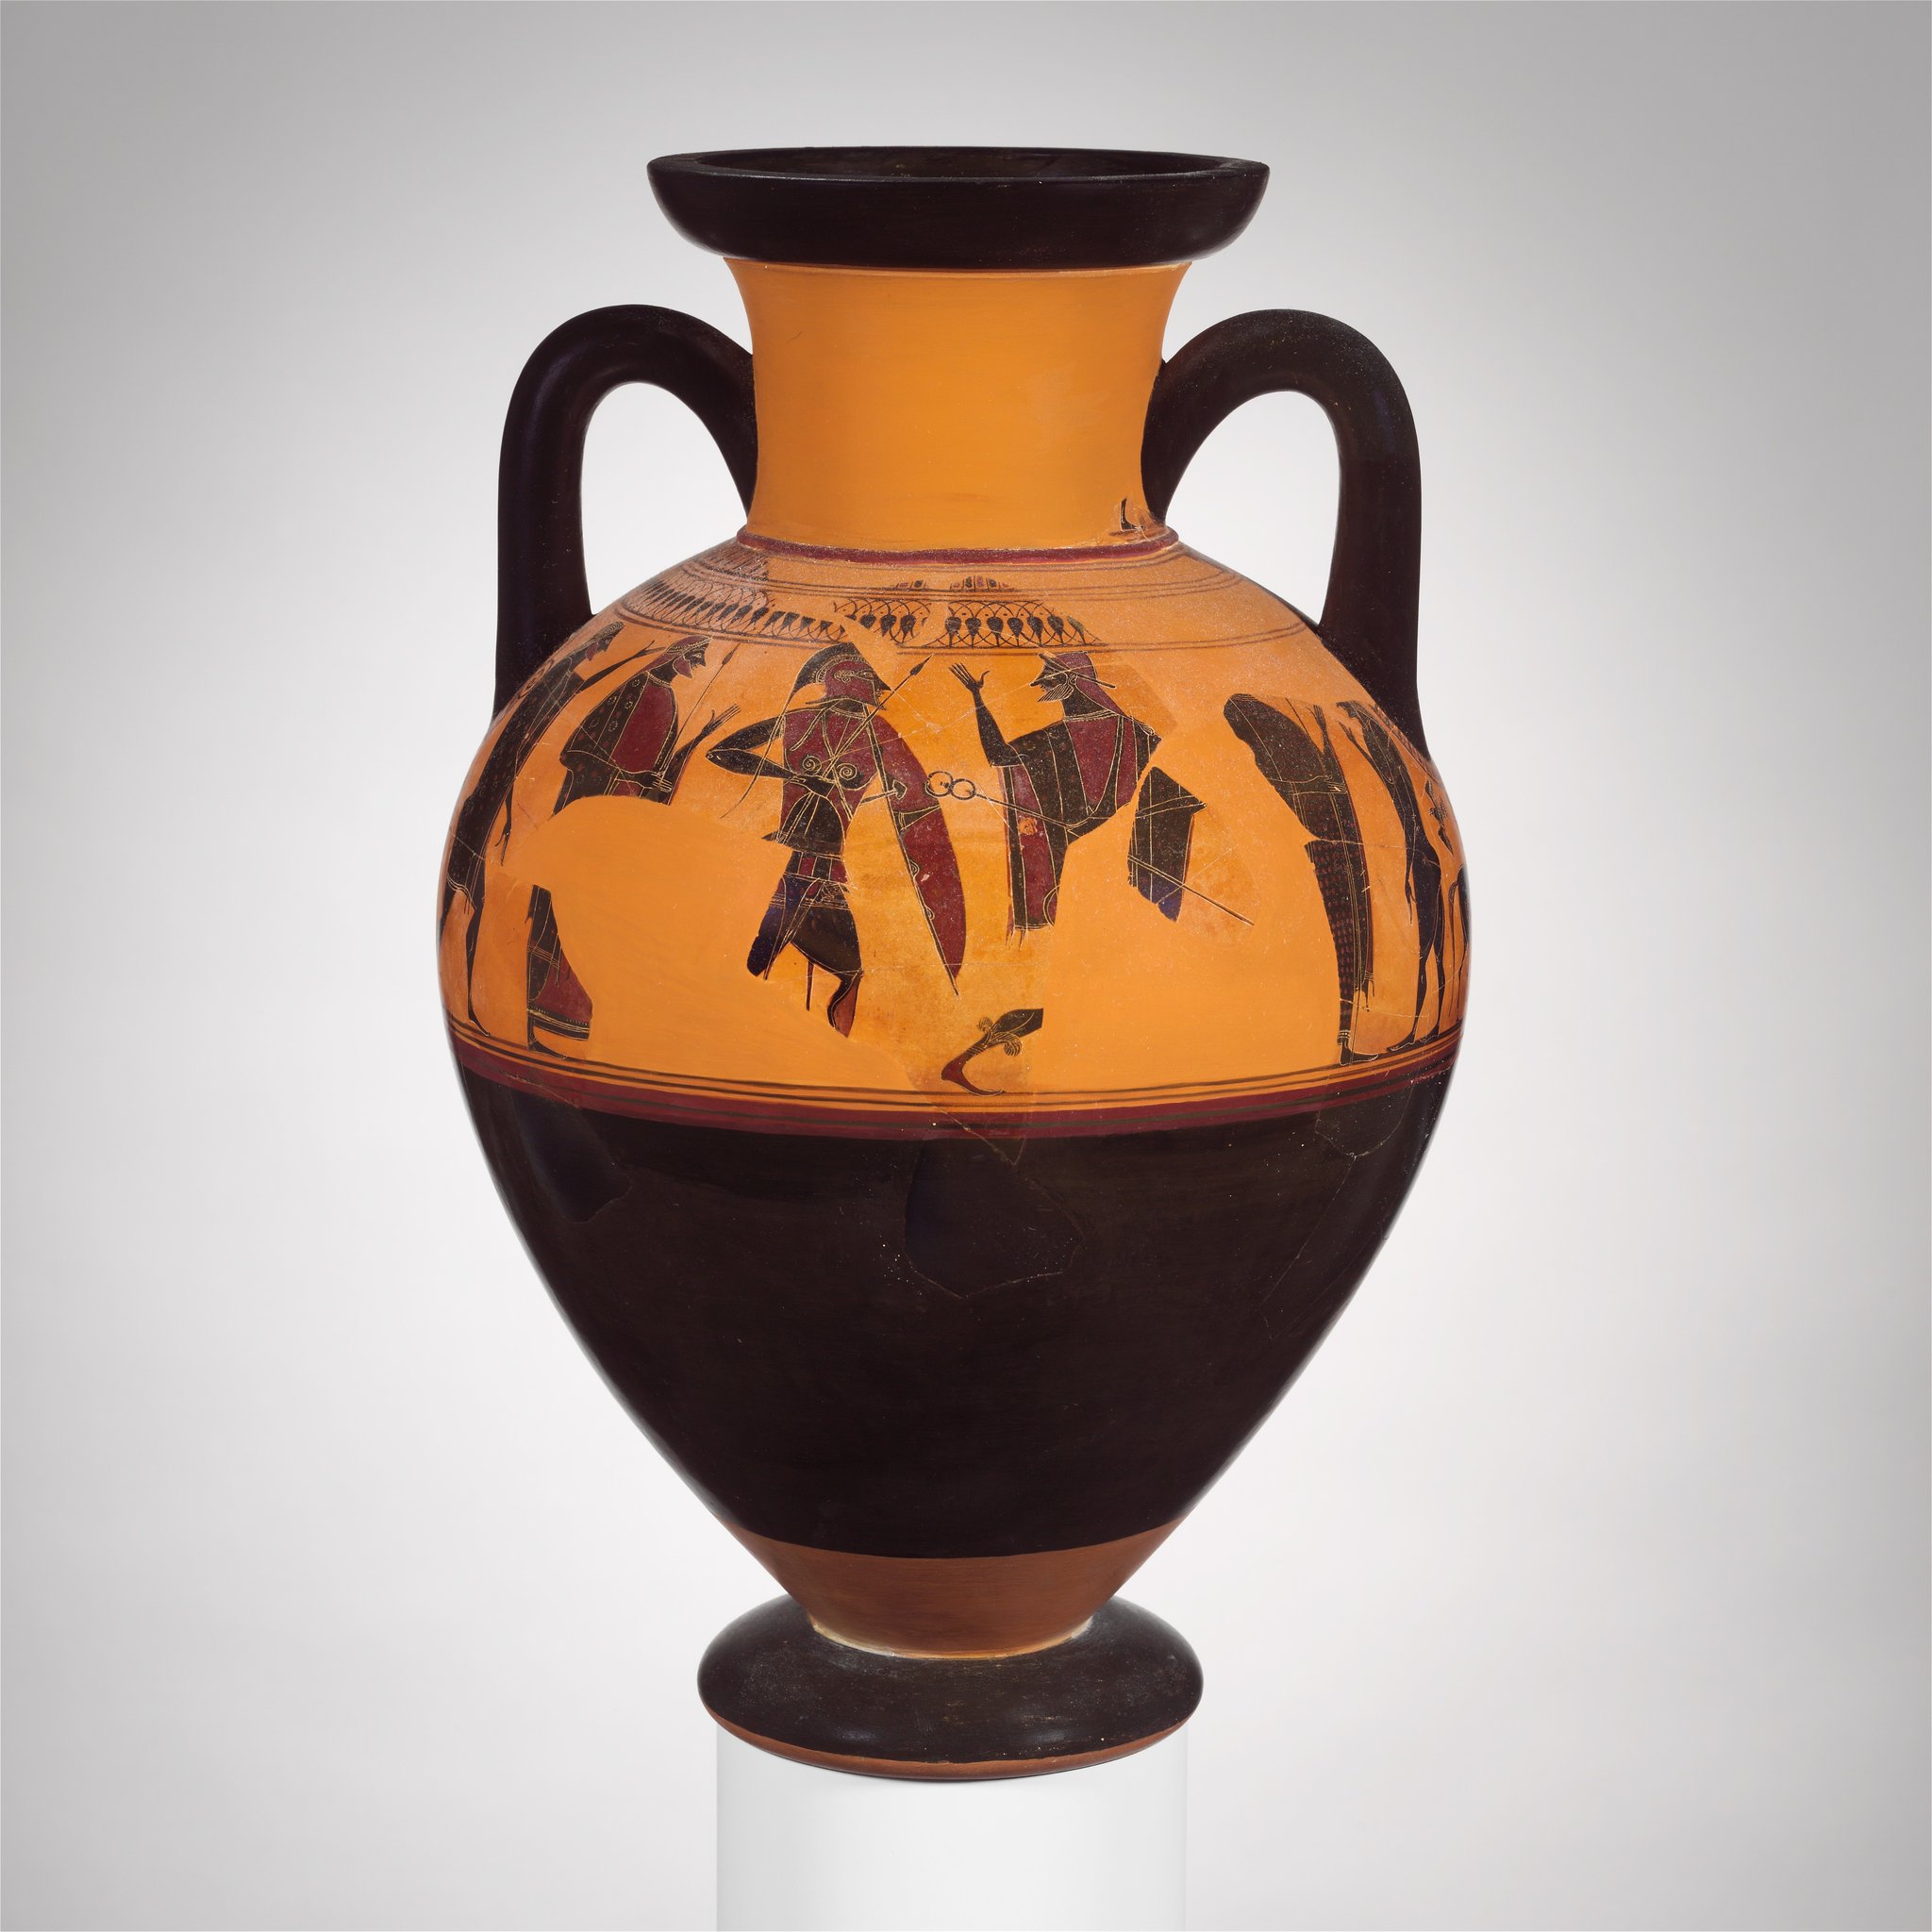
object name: neck amphora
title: Terracotta neck-amphora (jar)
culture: greek, attic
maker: affecter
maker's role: artist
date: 550-540 BCE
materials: terracotta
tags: birds,men,women,horses,warriors